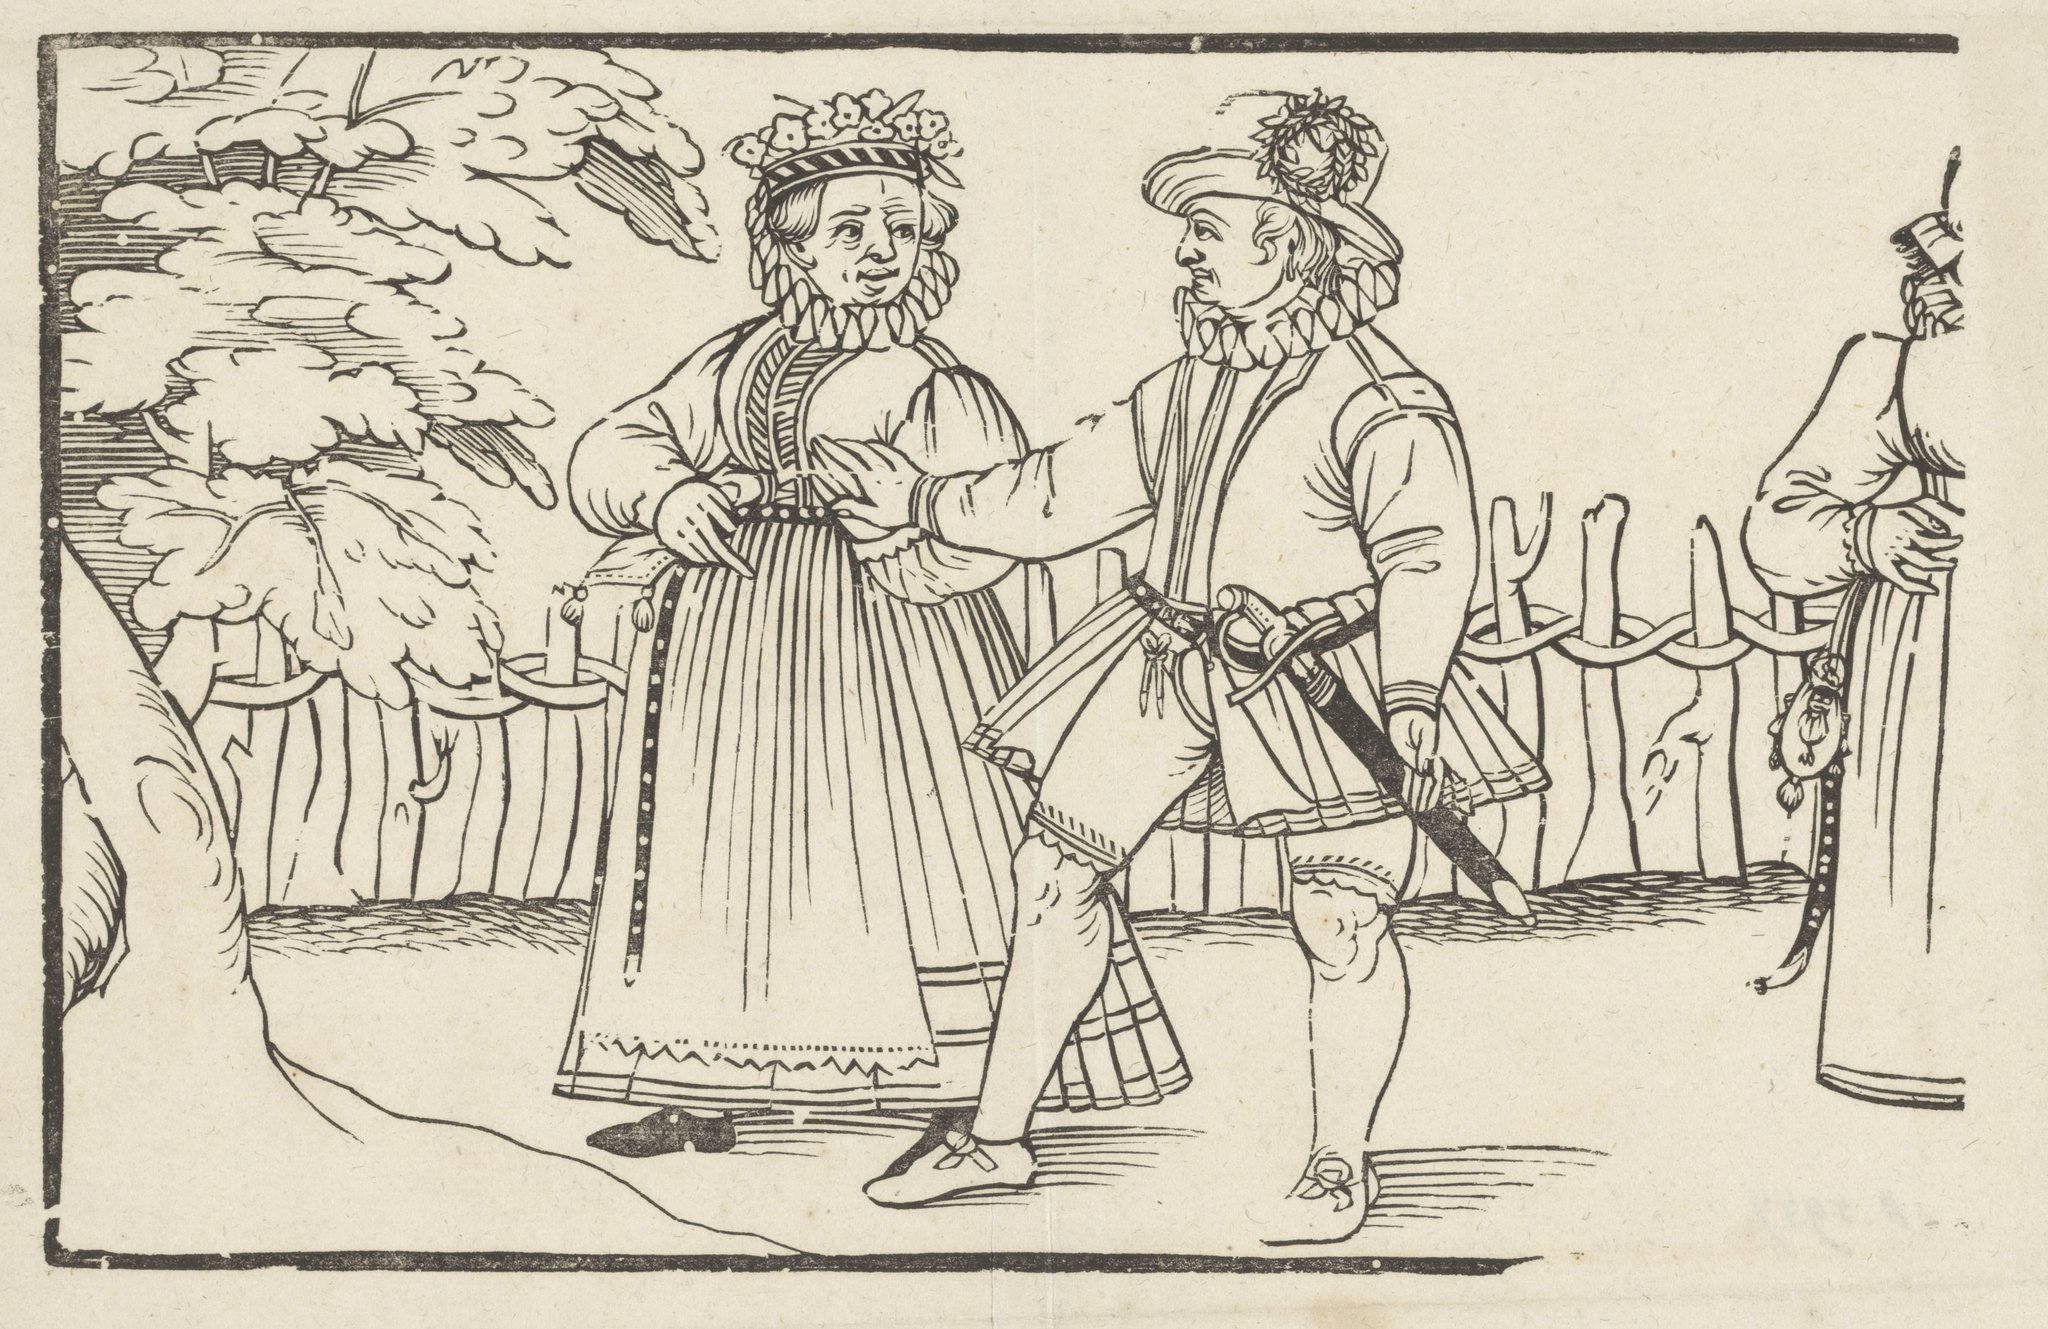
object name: print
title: Bruidspaar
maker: Anonymous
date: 1600-1699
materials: paper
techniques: woodcut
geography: netherlands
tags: bride and groom in wedding-dress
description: De bruid en de bruidegom geven elkaar de hand. Op de achtergrond staat een vrouw bij een hekwerk.